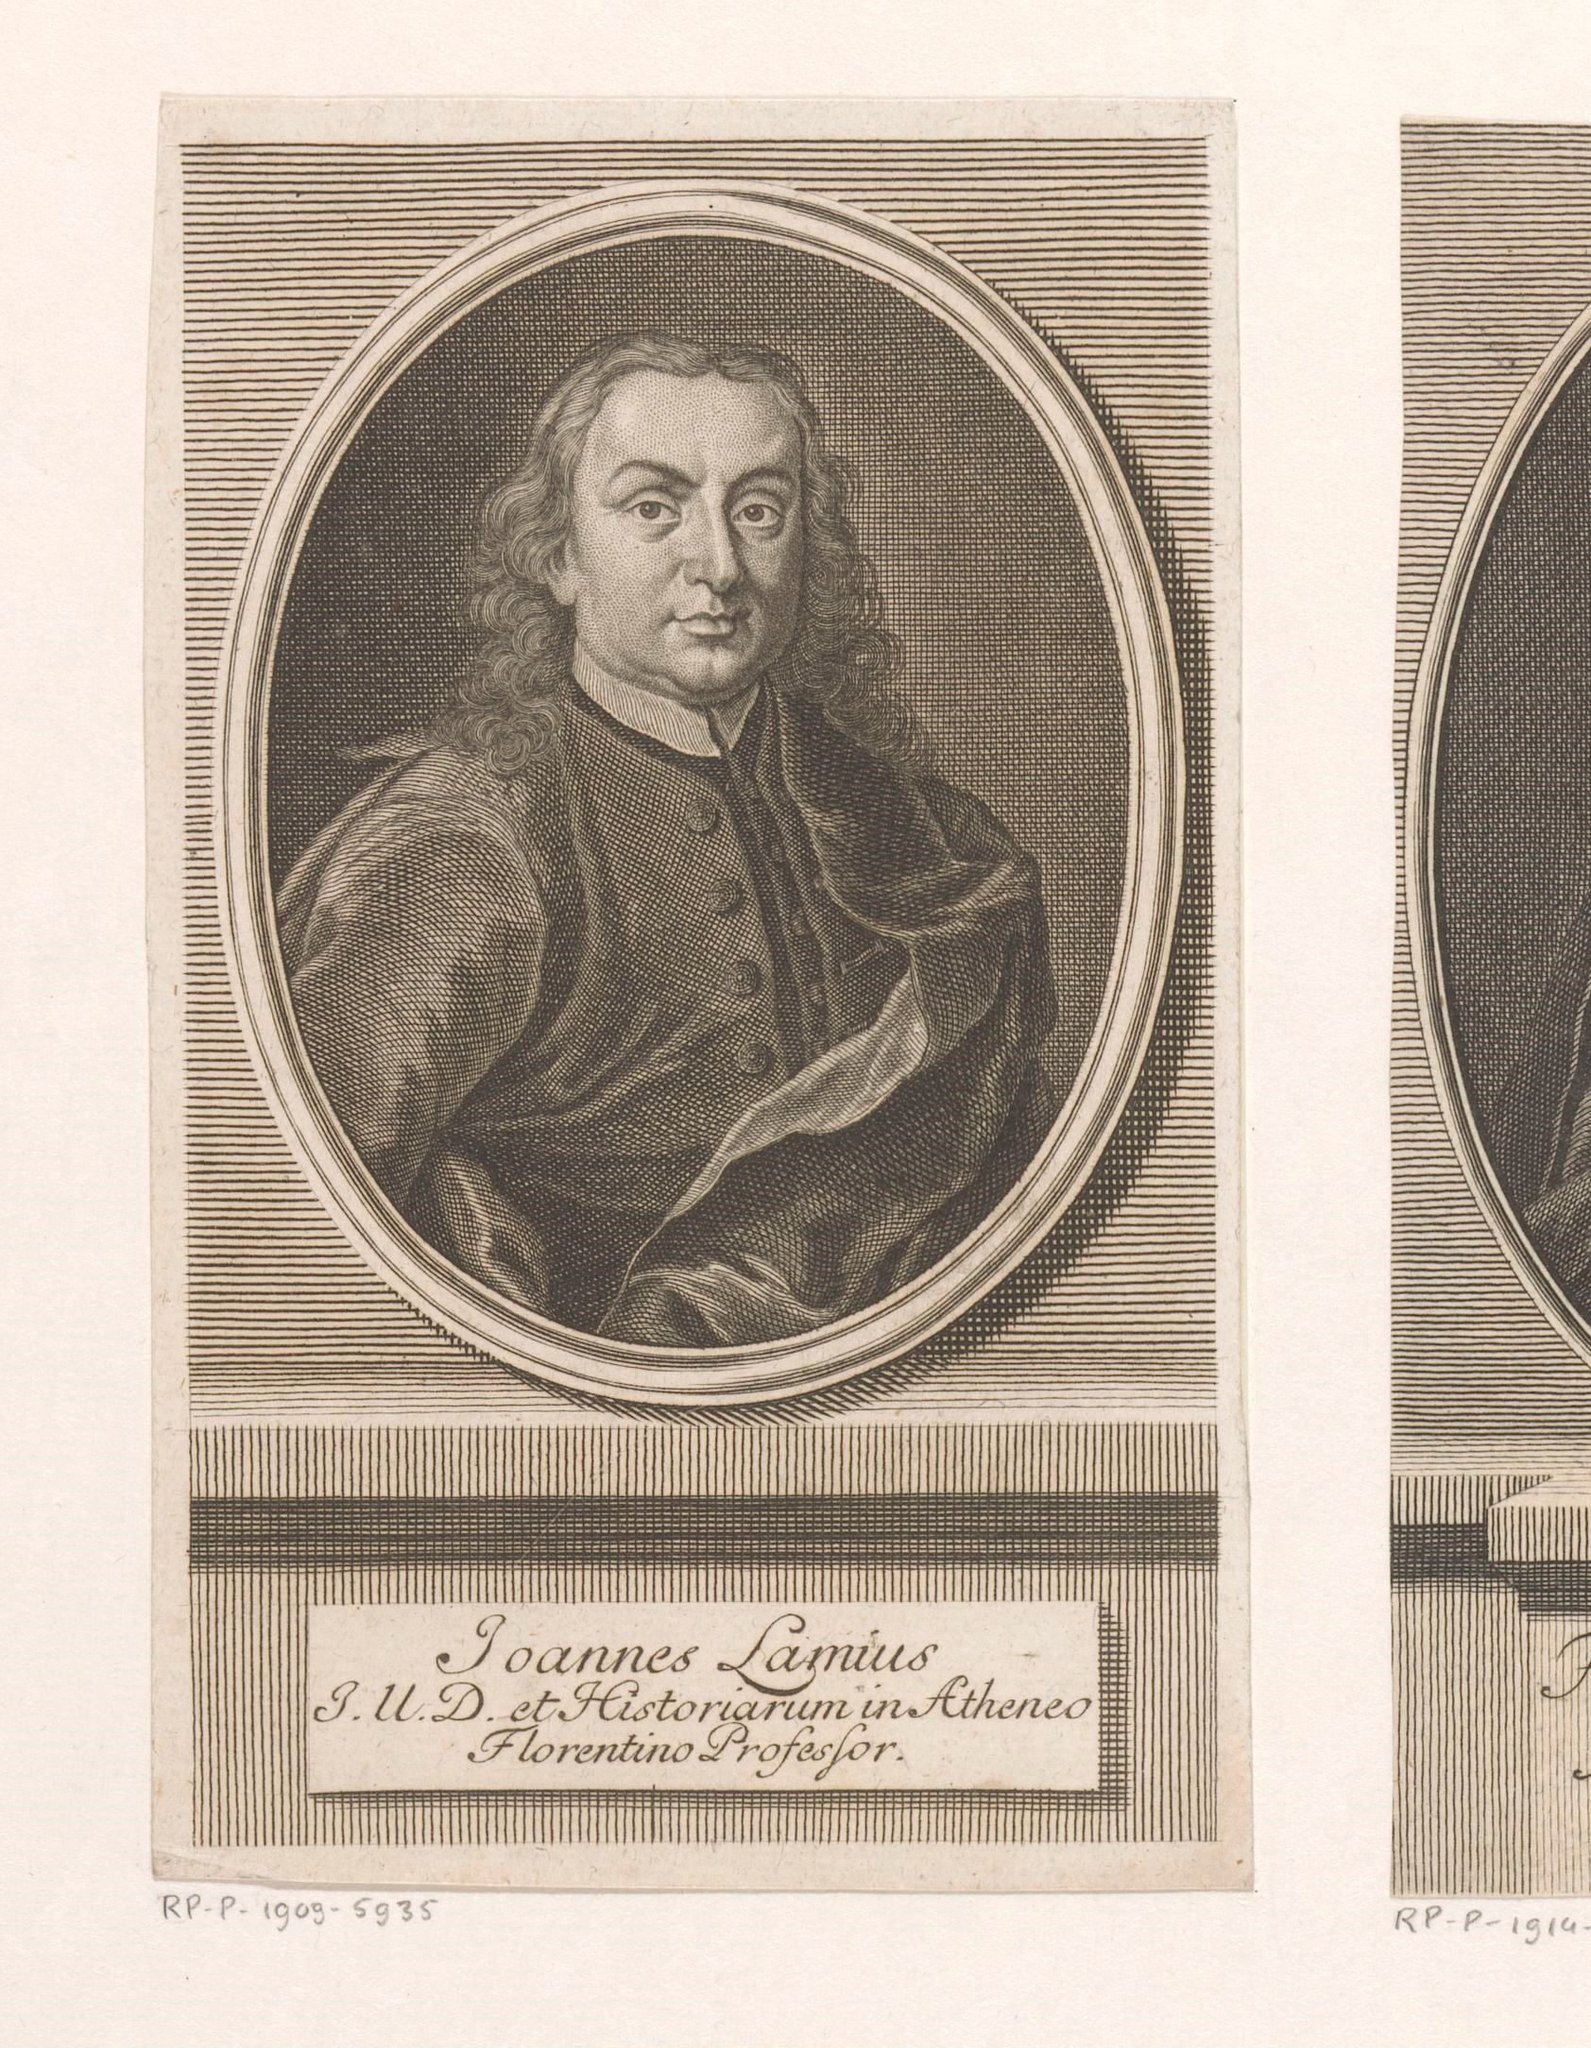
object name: print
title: Portret van Giovanni Lami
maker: johann martin bernigeroth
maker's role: print maker, publisher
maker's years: 1713-1767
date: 1747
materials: paper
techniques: engraving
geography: leipzig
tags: historical persons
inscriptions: collector's mark: Lugt 2228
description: Prent ook gebruikt in: Zuverlässige Nachrichten von dem gegenwärtigen Zustande, Veränderung und Wachsthum der Wissenschaften. dl. 85. Leipzig: Johann Friedrich Gleditsch, 1747.